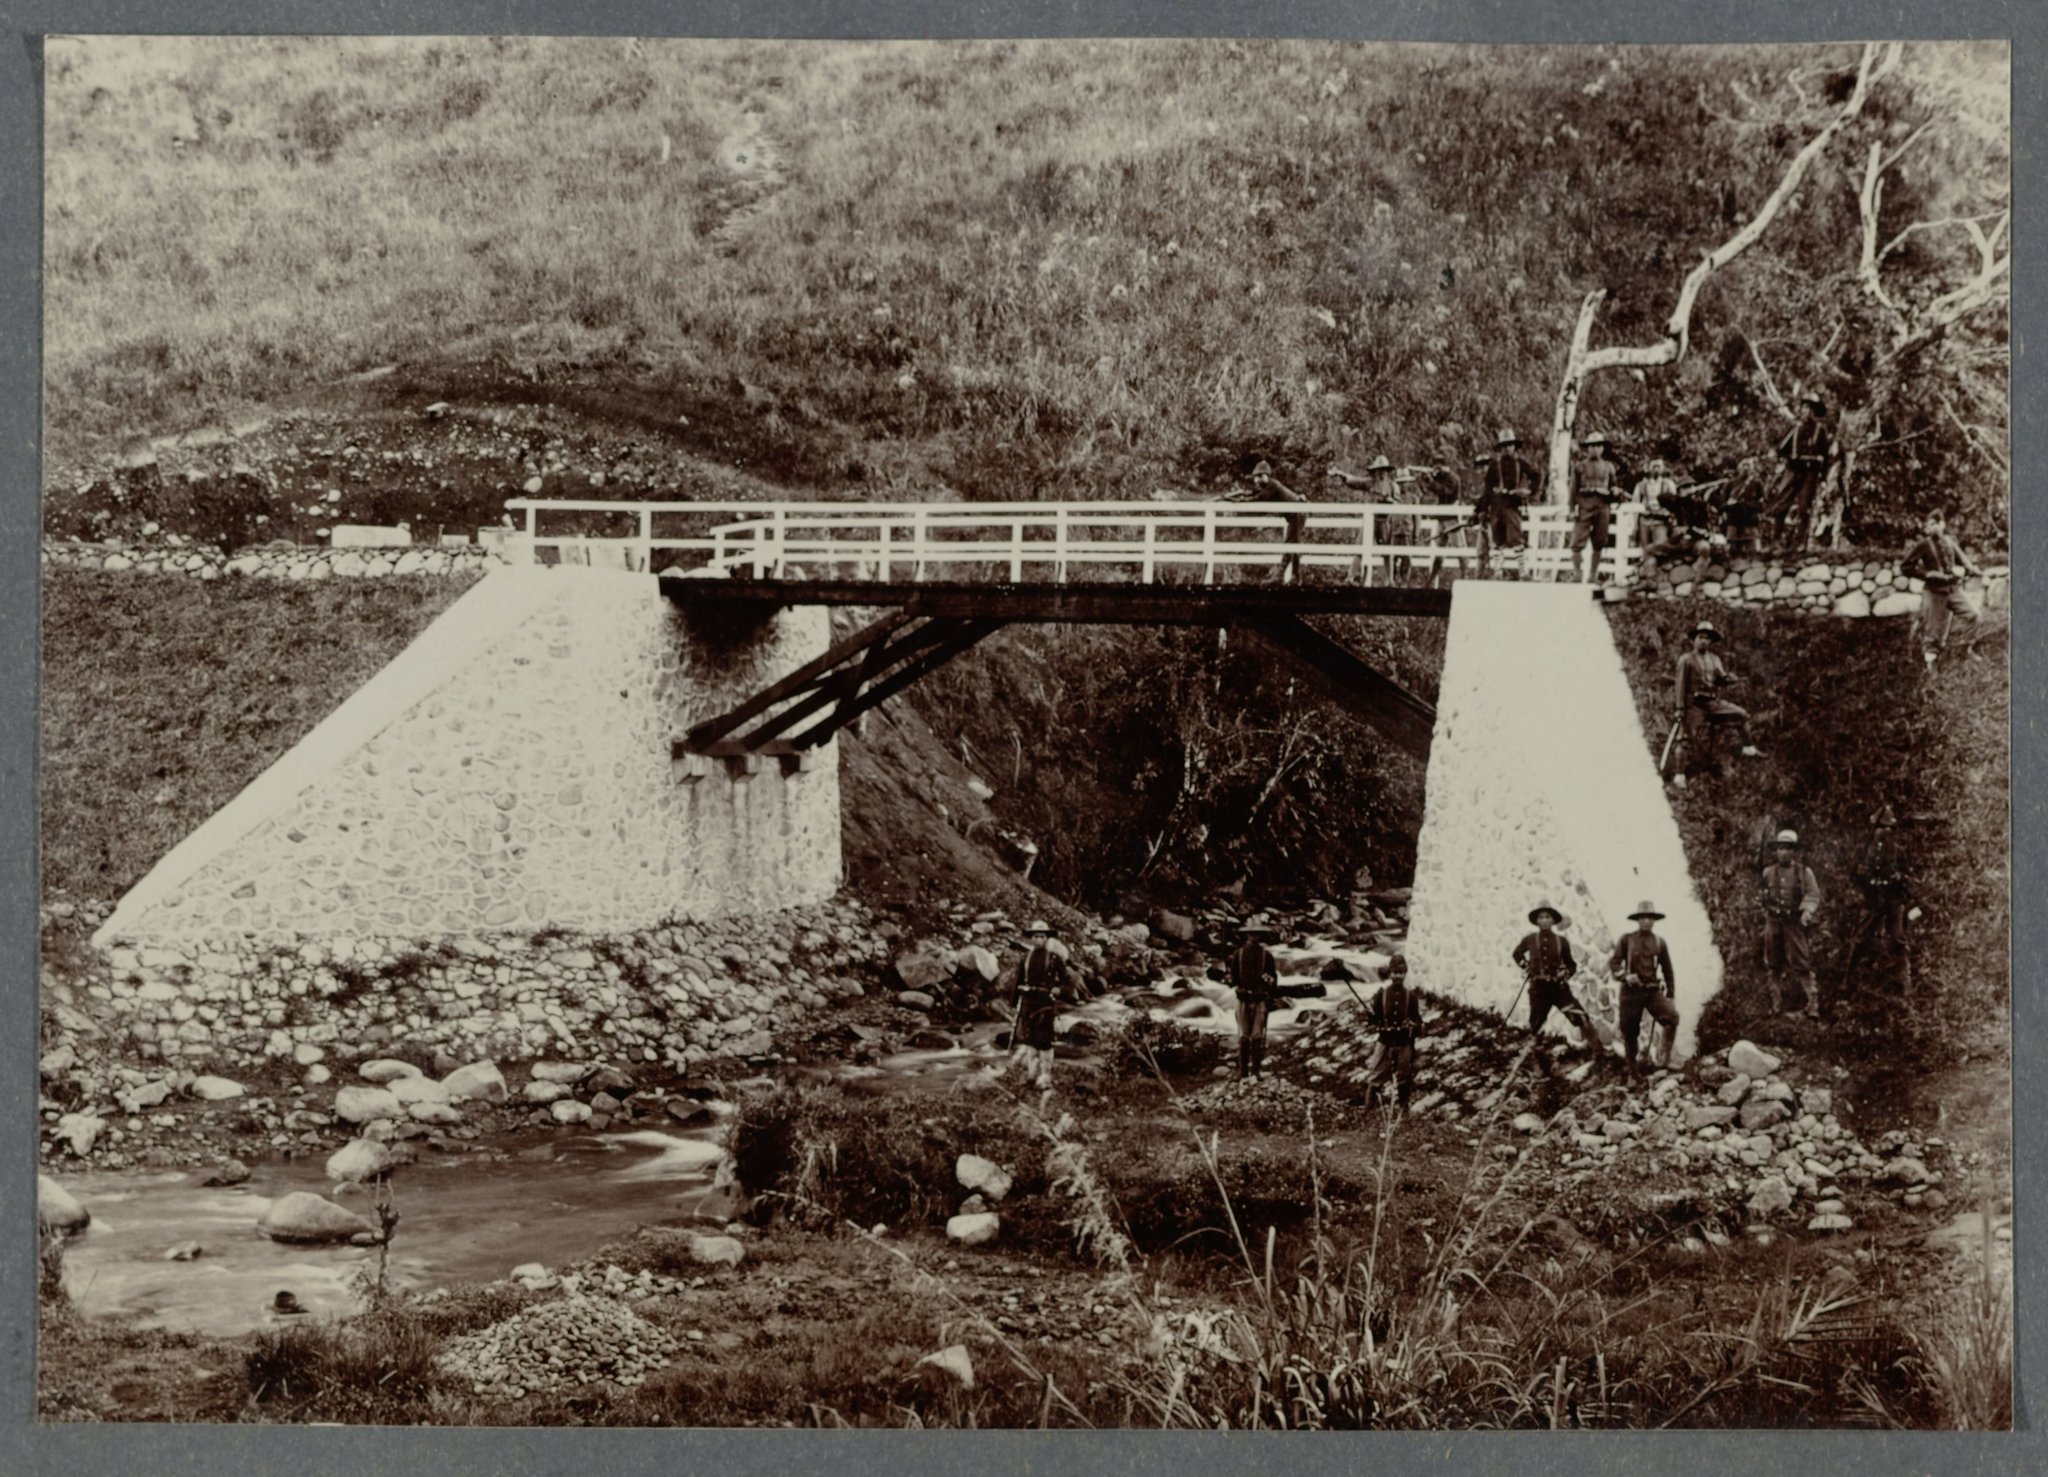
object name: photograph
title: Brug over de Wenih Rongka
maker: Anonymous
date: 1903-1913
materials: photographic support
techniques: gelatin silver print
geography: north sumatra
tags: albertus dominicus laman trip, building activities, traffic by road or path with motor-vehicle, landscapes in tropical and sub-tropical regions, road, path, bridge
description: Na de expedities naar de Gajo- en Alaslanden o.l.v. Van Daalen (eerste tocht in 1901), werd hij in 1903 belast met voorbereiding van permanente vestiging van Nederlands gezag. Aanleg van een weg van de Noordkust naar het binnenland was hierbij van groot belang. Deze zgn. Gajoweg werd aangelegd tussen 1903 en 1914, van Bireuen aan de kust naar Takinguen aan het bergmeer Danau Lauttawar, totale lengte 104 km.